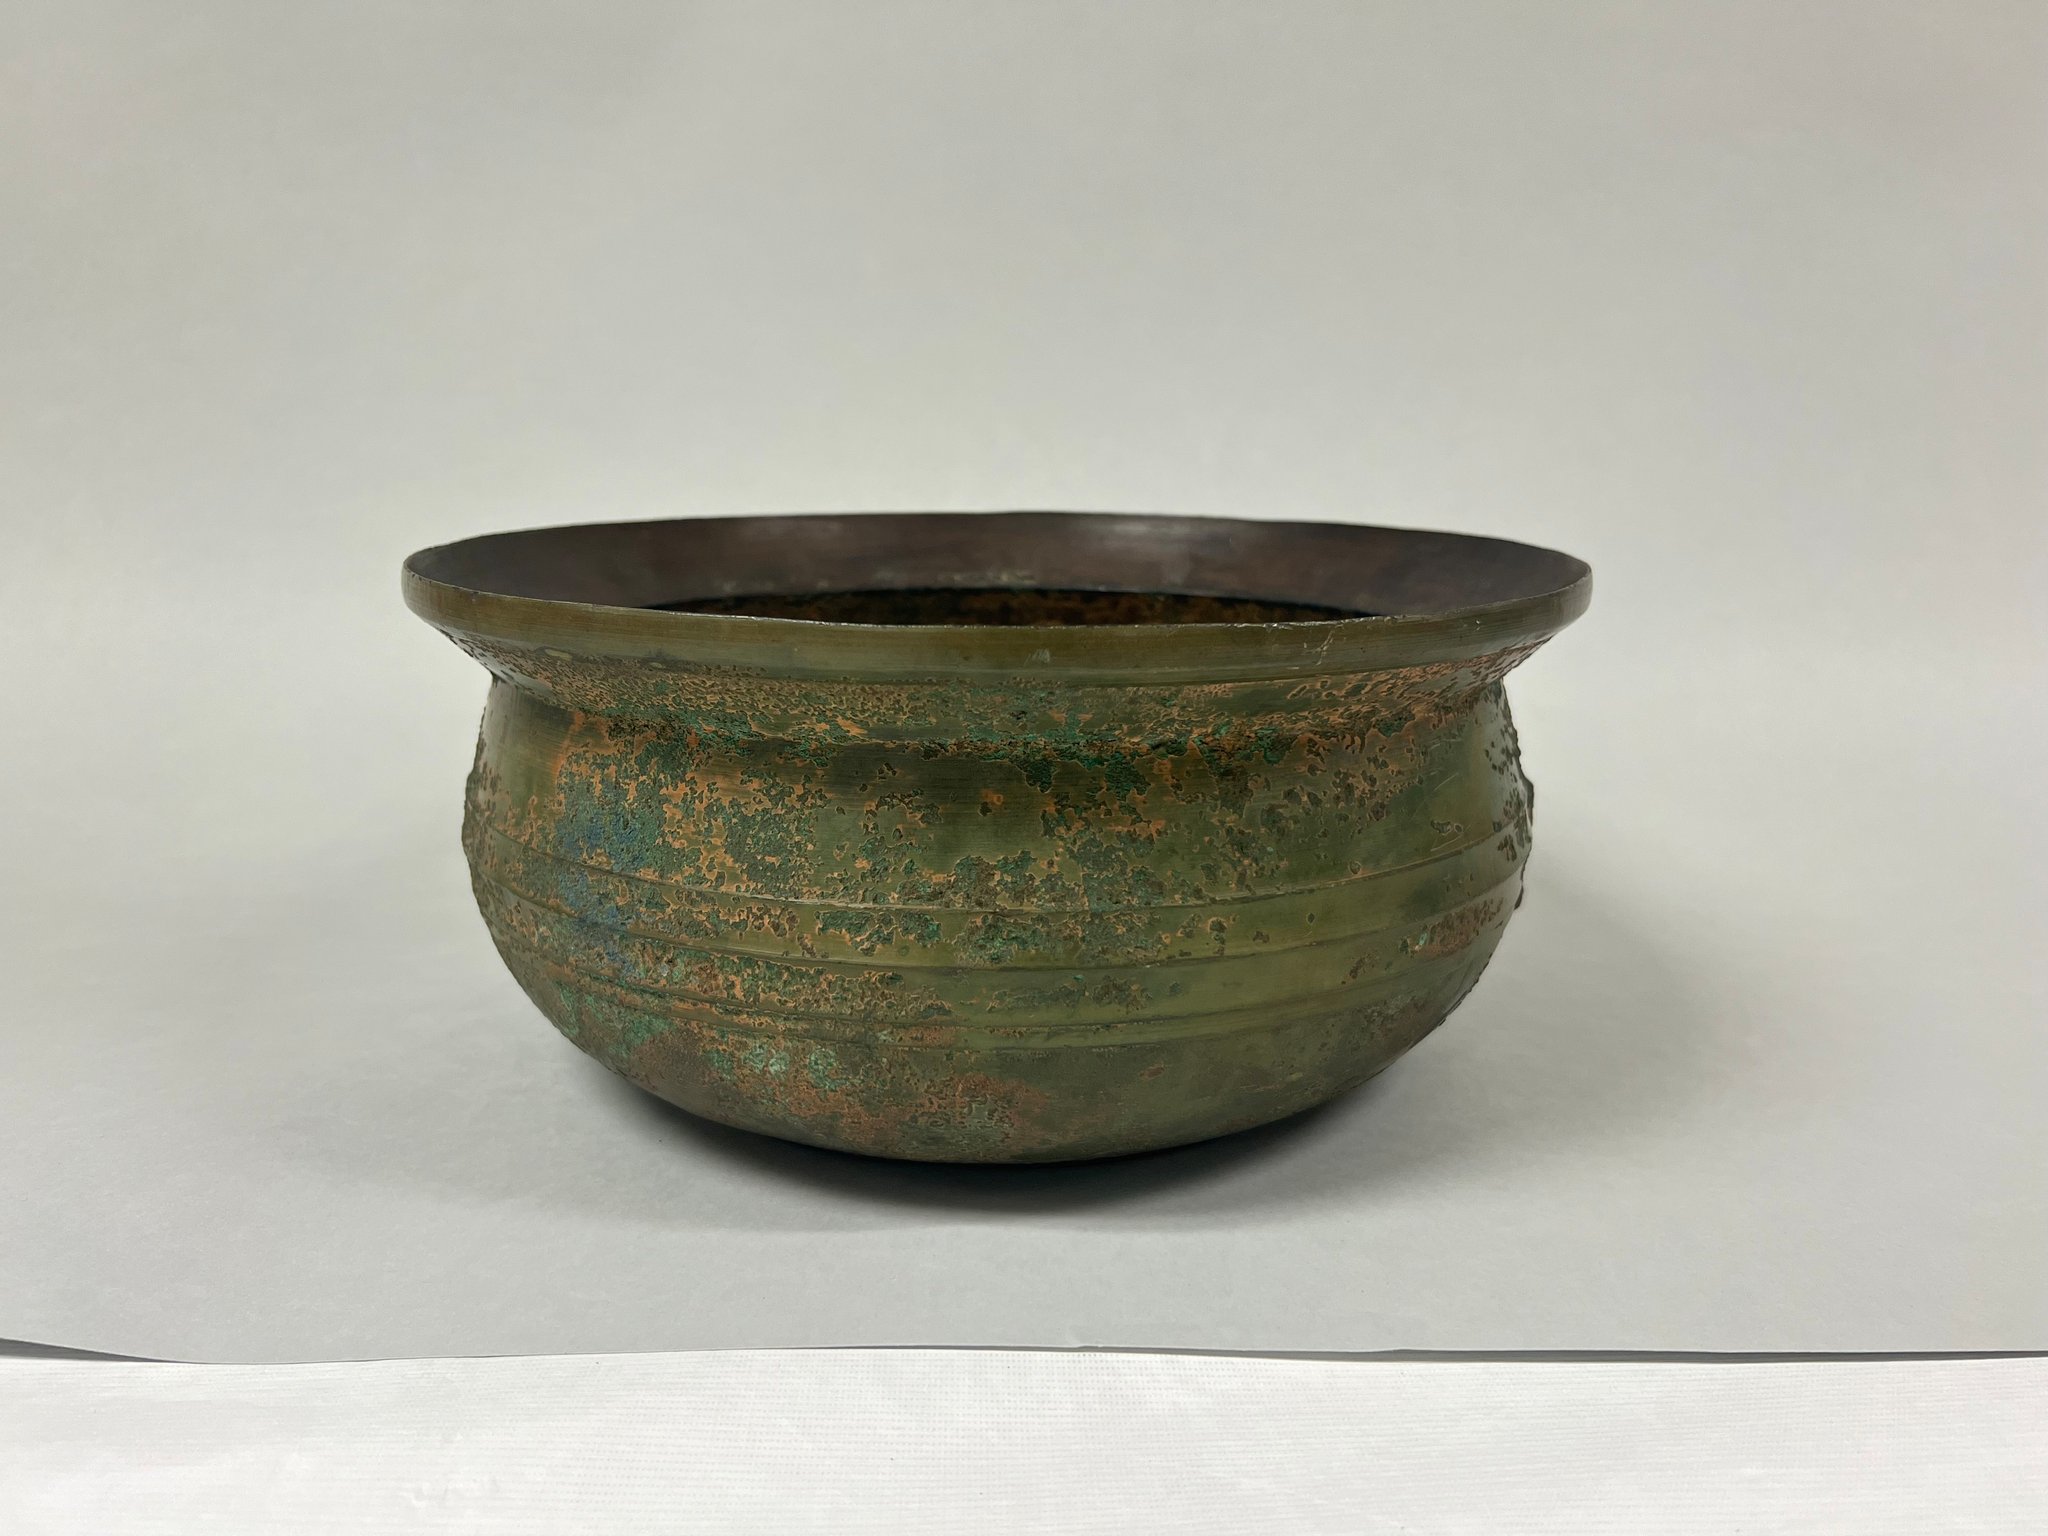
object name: bowl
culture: chinese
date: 206 BCE-220 CE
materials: bronze